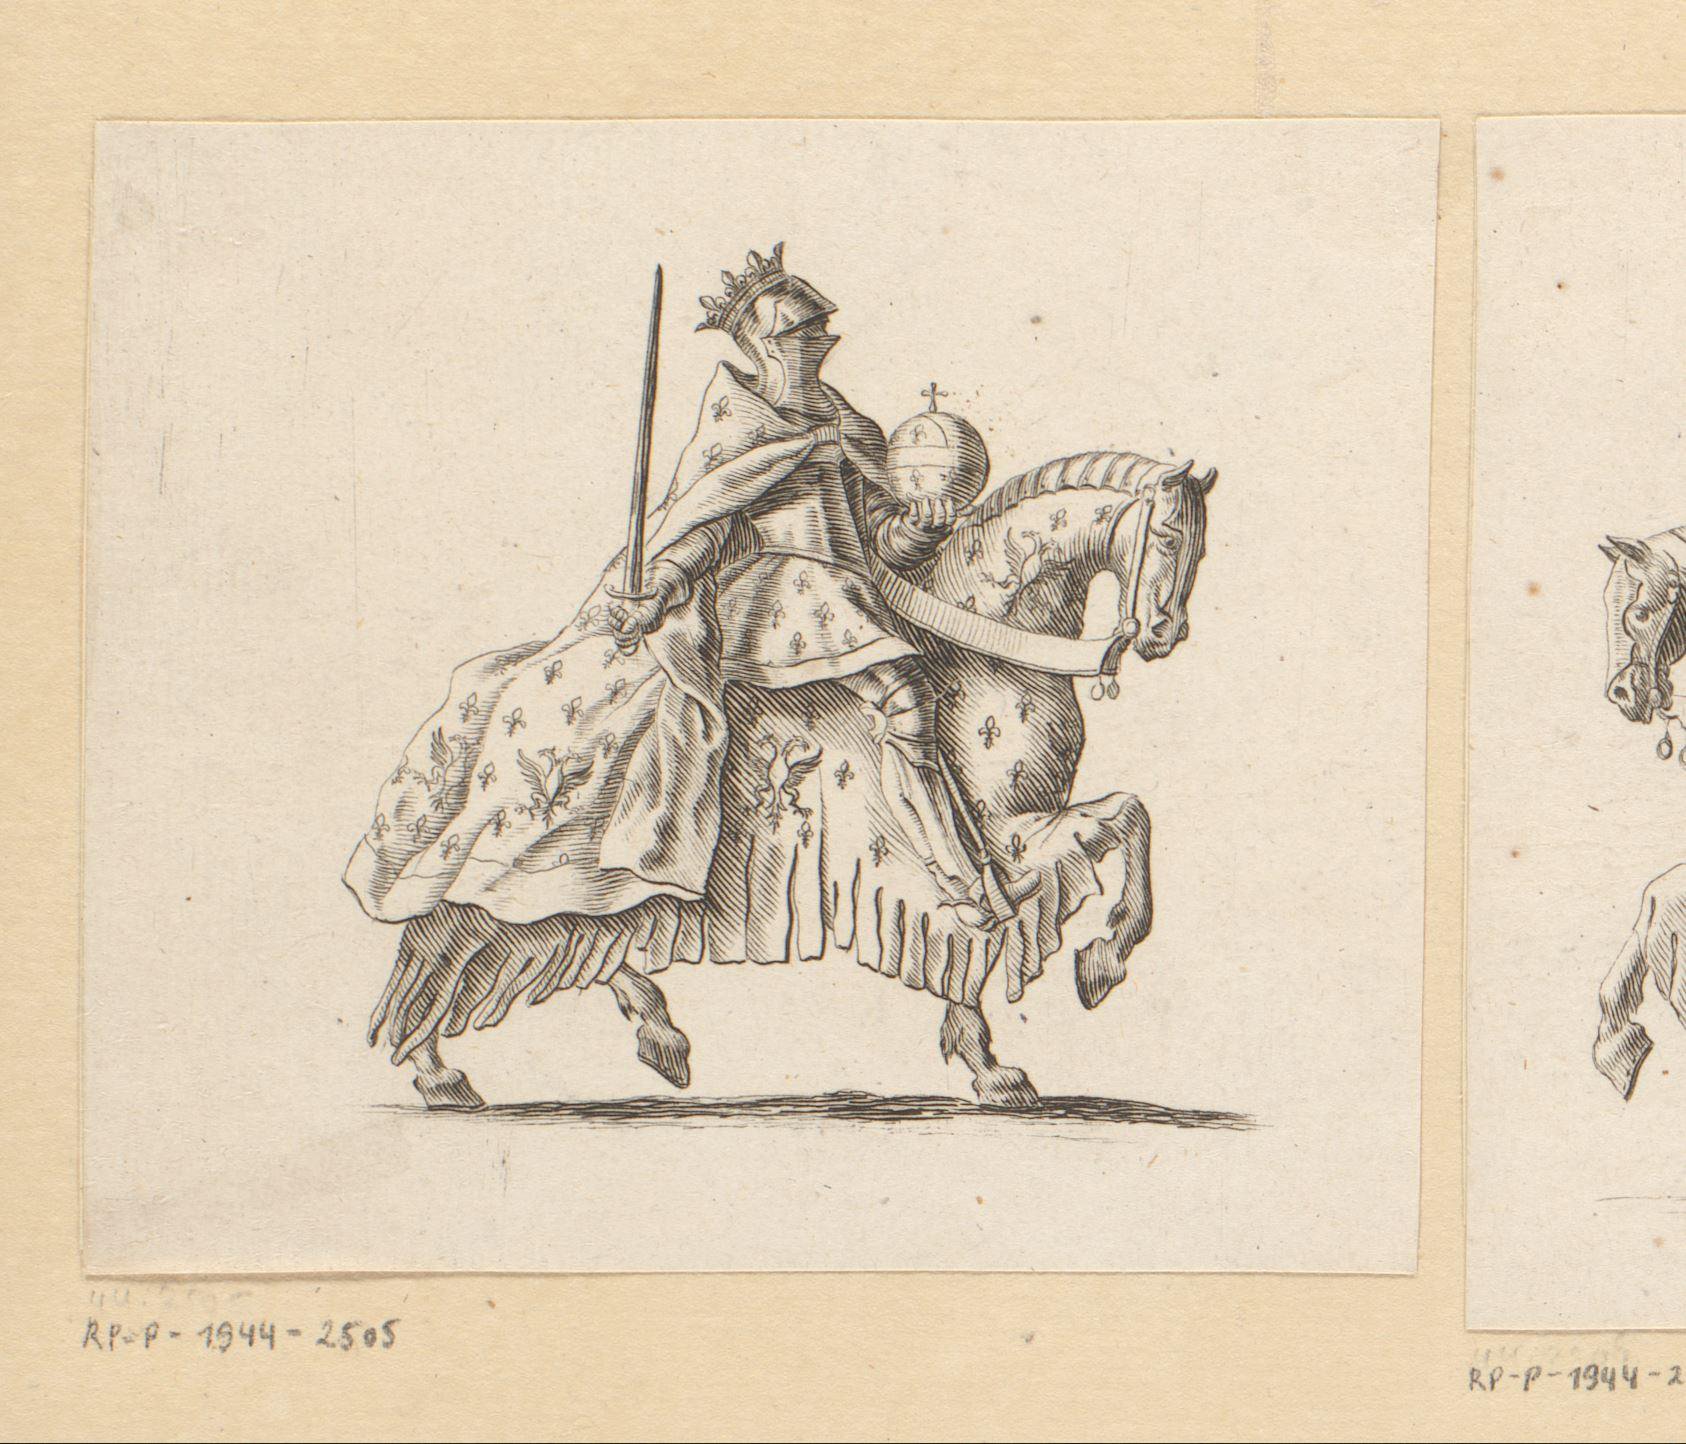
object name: print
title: Ridder te paard in wapenuitrusting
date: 1647-1714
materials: paper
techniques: engraving, etching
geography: france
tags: riding a horse, ass, or mule; rider, horseman, armour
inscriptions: collector's mark: Lugt 240